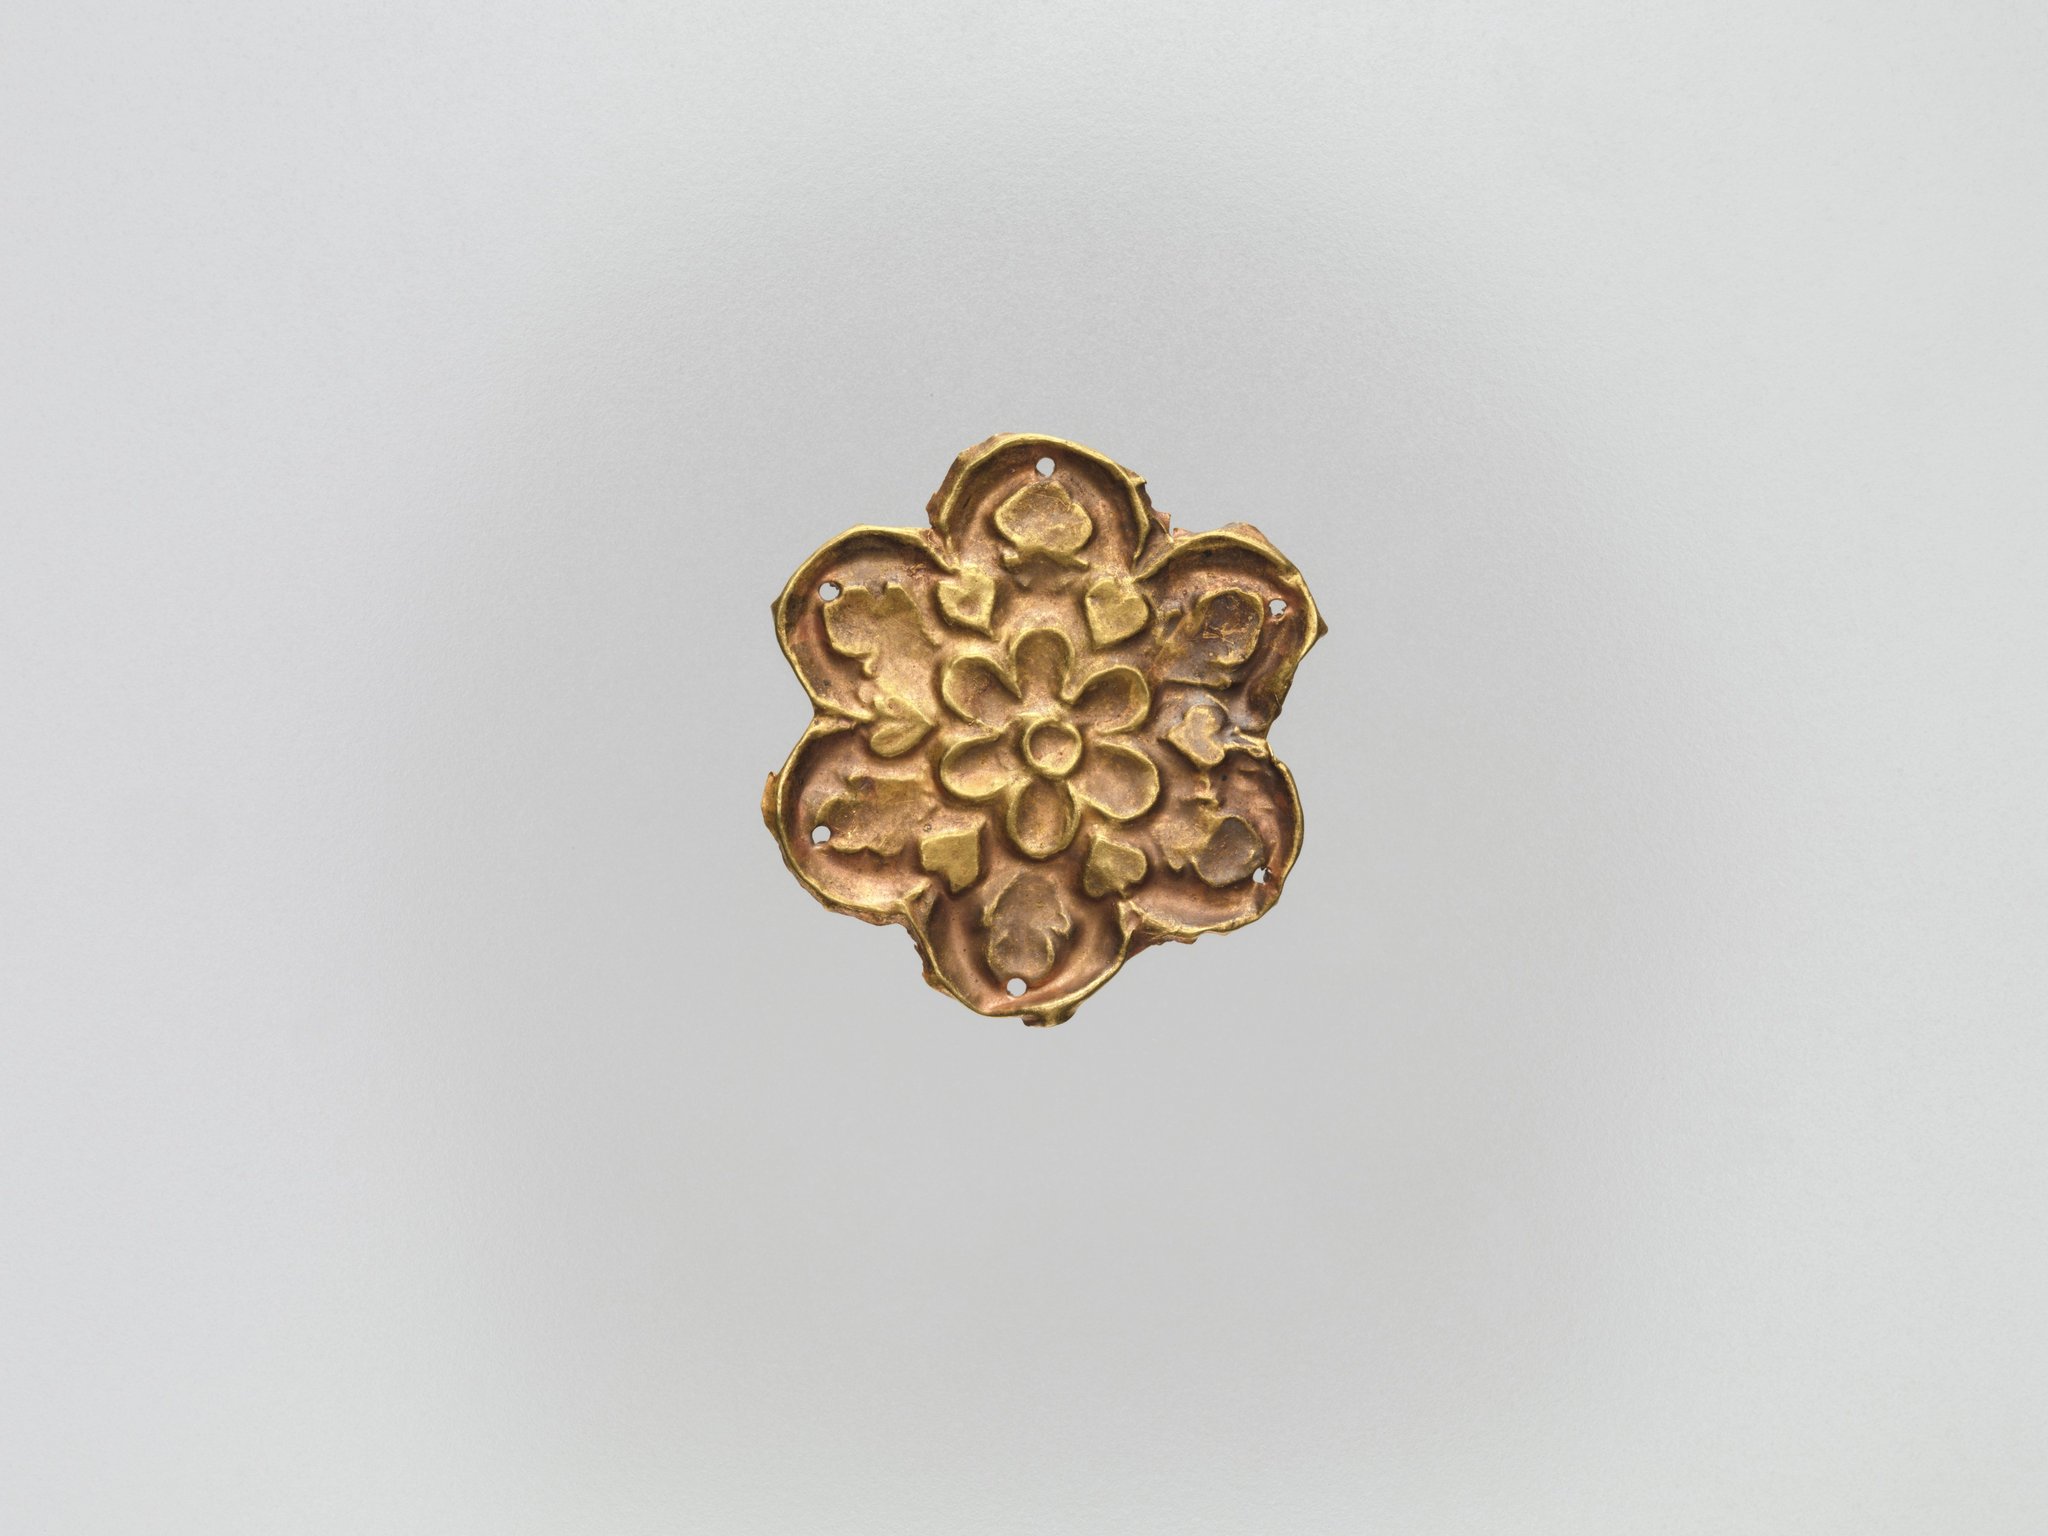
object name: garment plaque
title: Flower-Shaped Clothing Plaque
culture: chinese or central asian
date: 601-900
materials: gold